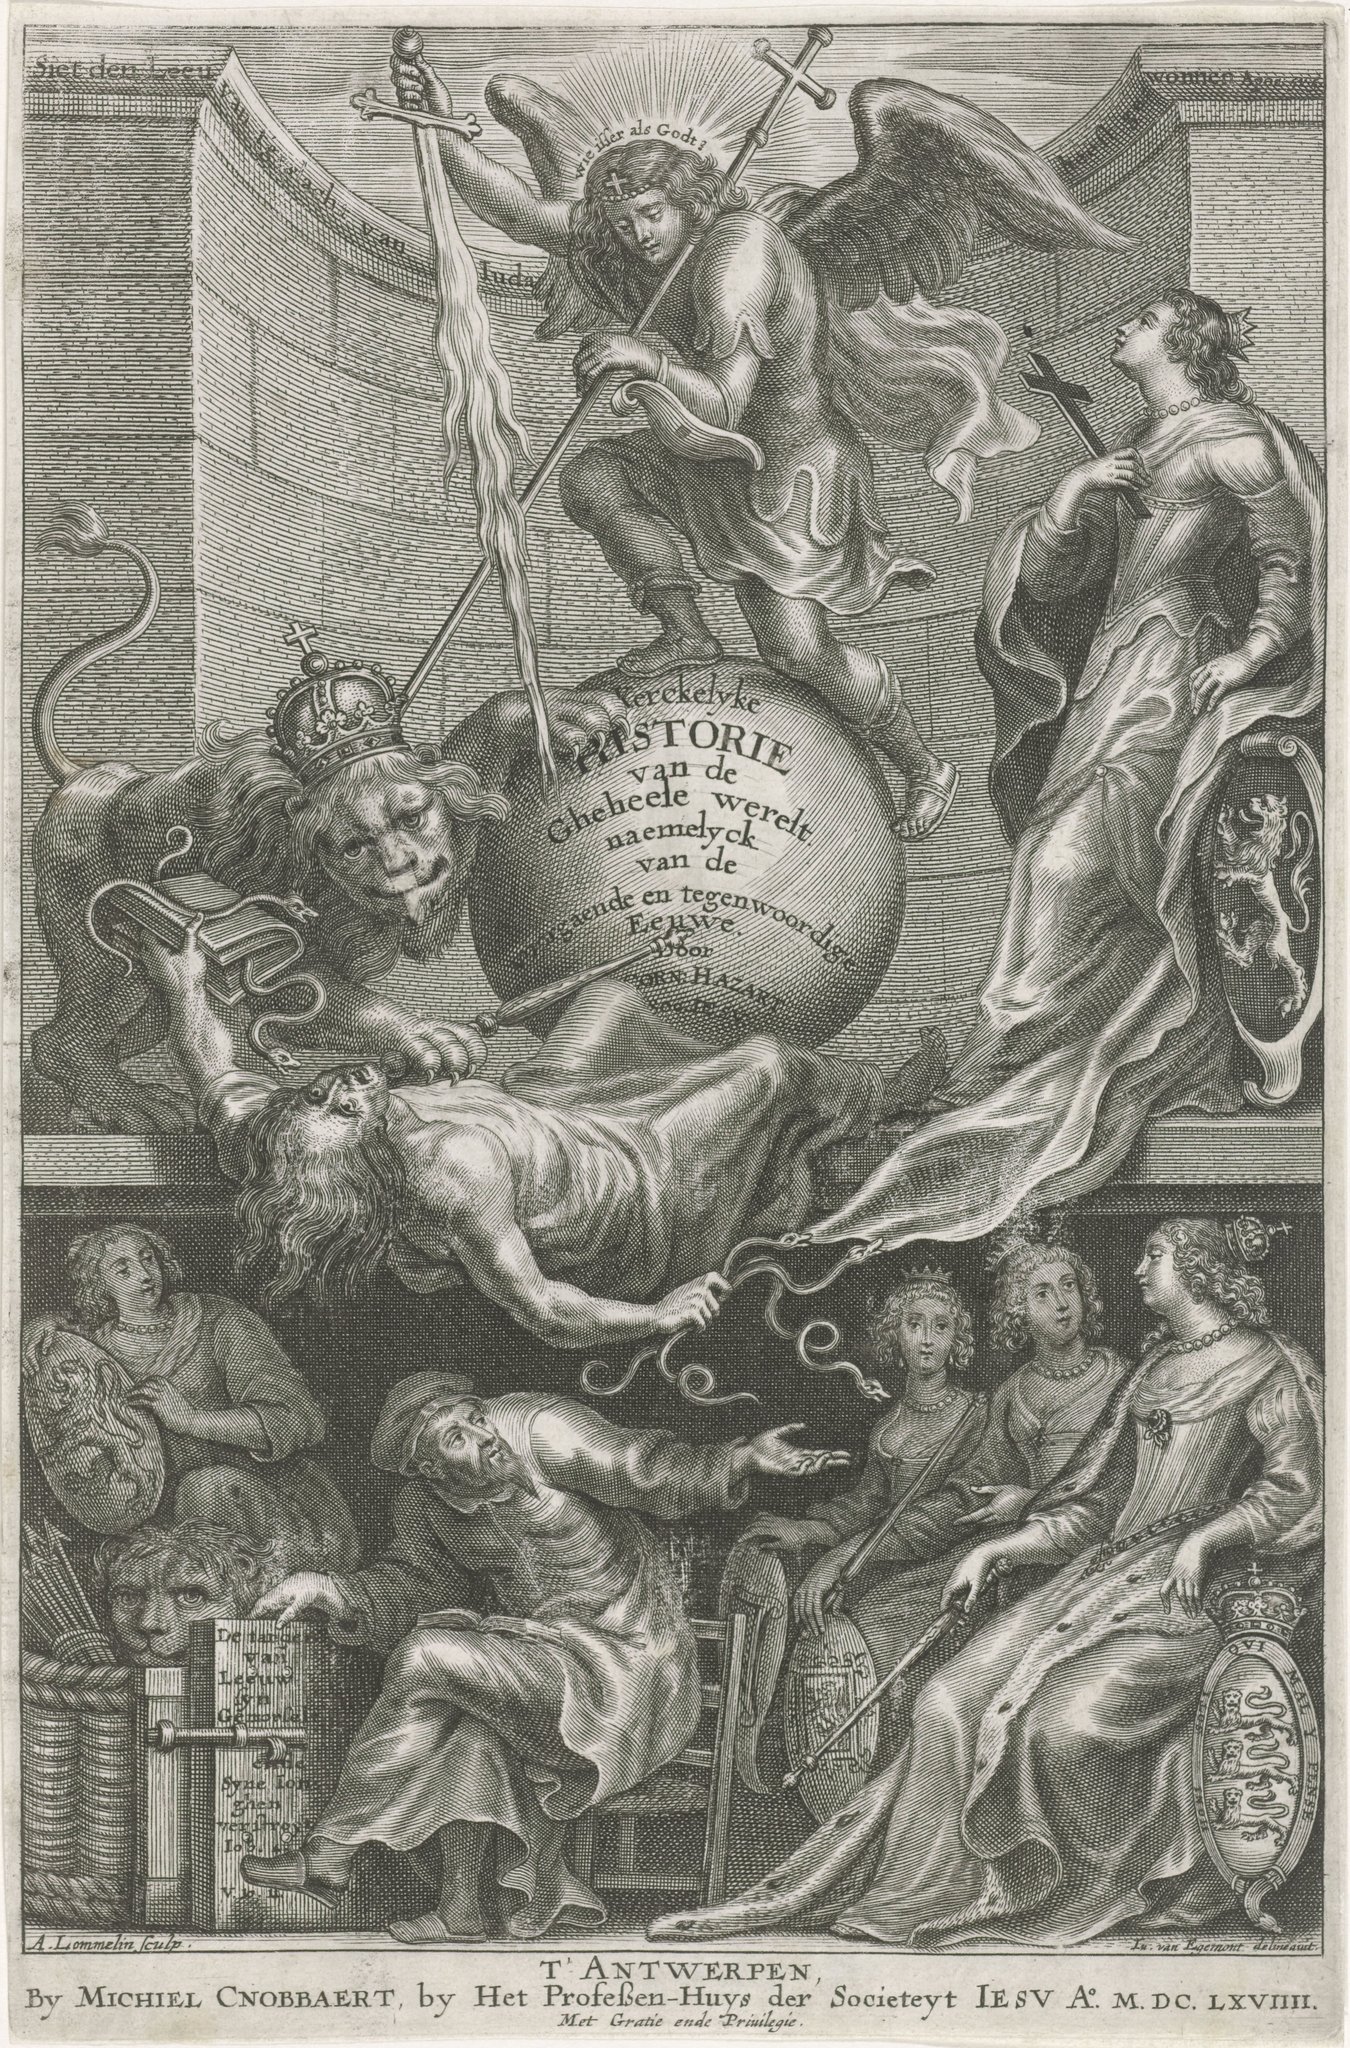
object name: titelblad, titelpagina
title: Titelpagina voor: C. Hazart, Kerckelycke historie, 1669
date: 1669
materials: paper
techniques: engraving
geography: antwerp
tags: angels fighting against other evil powers, coat of arms (as symbol of the state, etc.) (+ city; municipal), personifications of countries, nations, states, districts, etc., envy; 'invidia' (ripa) ~ personification of one of the seven deadly sins, the church personified, 'ecclesia', usually with chalice and banner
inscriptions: collector's mark: Lugt 2228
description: Een engel staat met een vlammend zwaard op een wereldbol waarop de titel van het boek staat. Links valt een gekroonde leeuw de Afgunst aan, rechts kijkt Ecclesia toe. Onder dit tafereel wijst een op een stoel gezeten man op drie gekroonde vrouwelijke personificaties met scepters en verschillende wapenschilden. Links zit de Hollandse Leeuw met een bundel pijlen binnen de omheining van de Hollandse tuin, hierachter staat een vierde vrouwelijke personificatie met het wapen van de Republiek in haar handen.